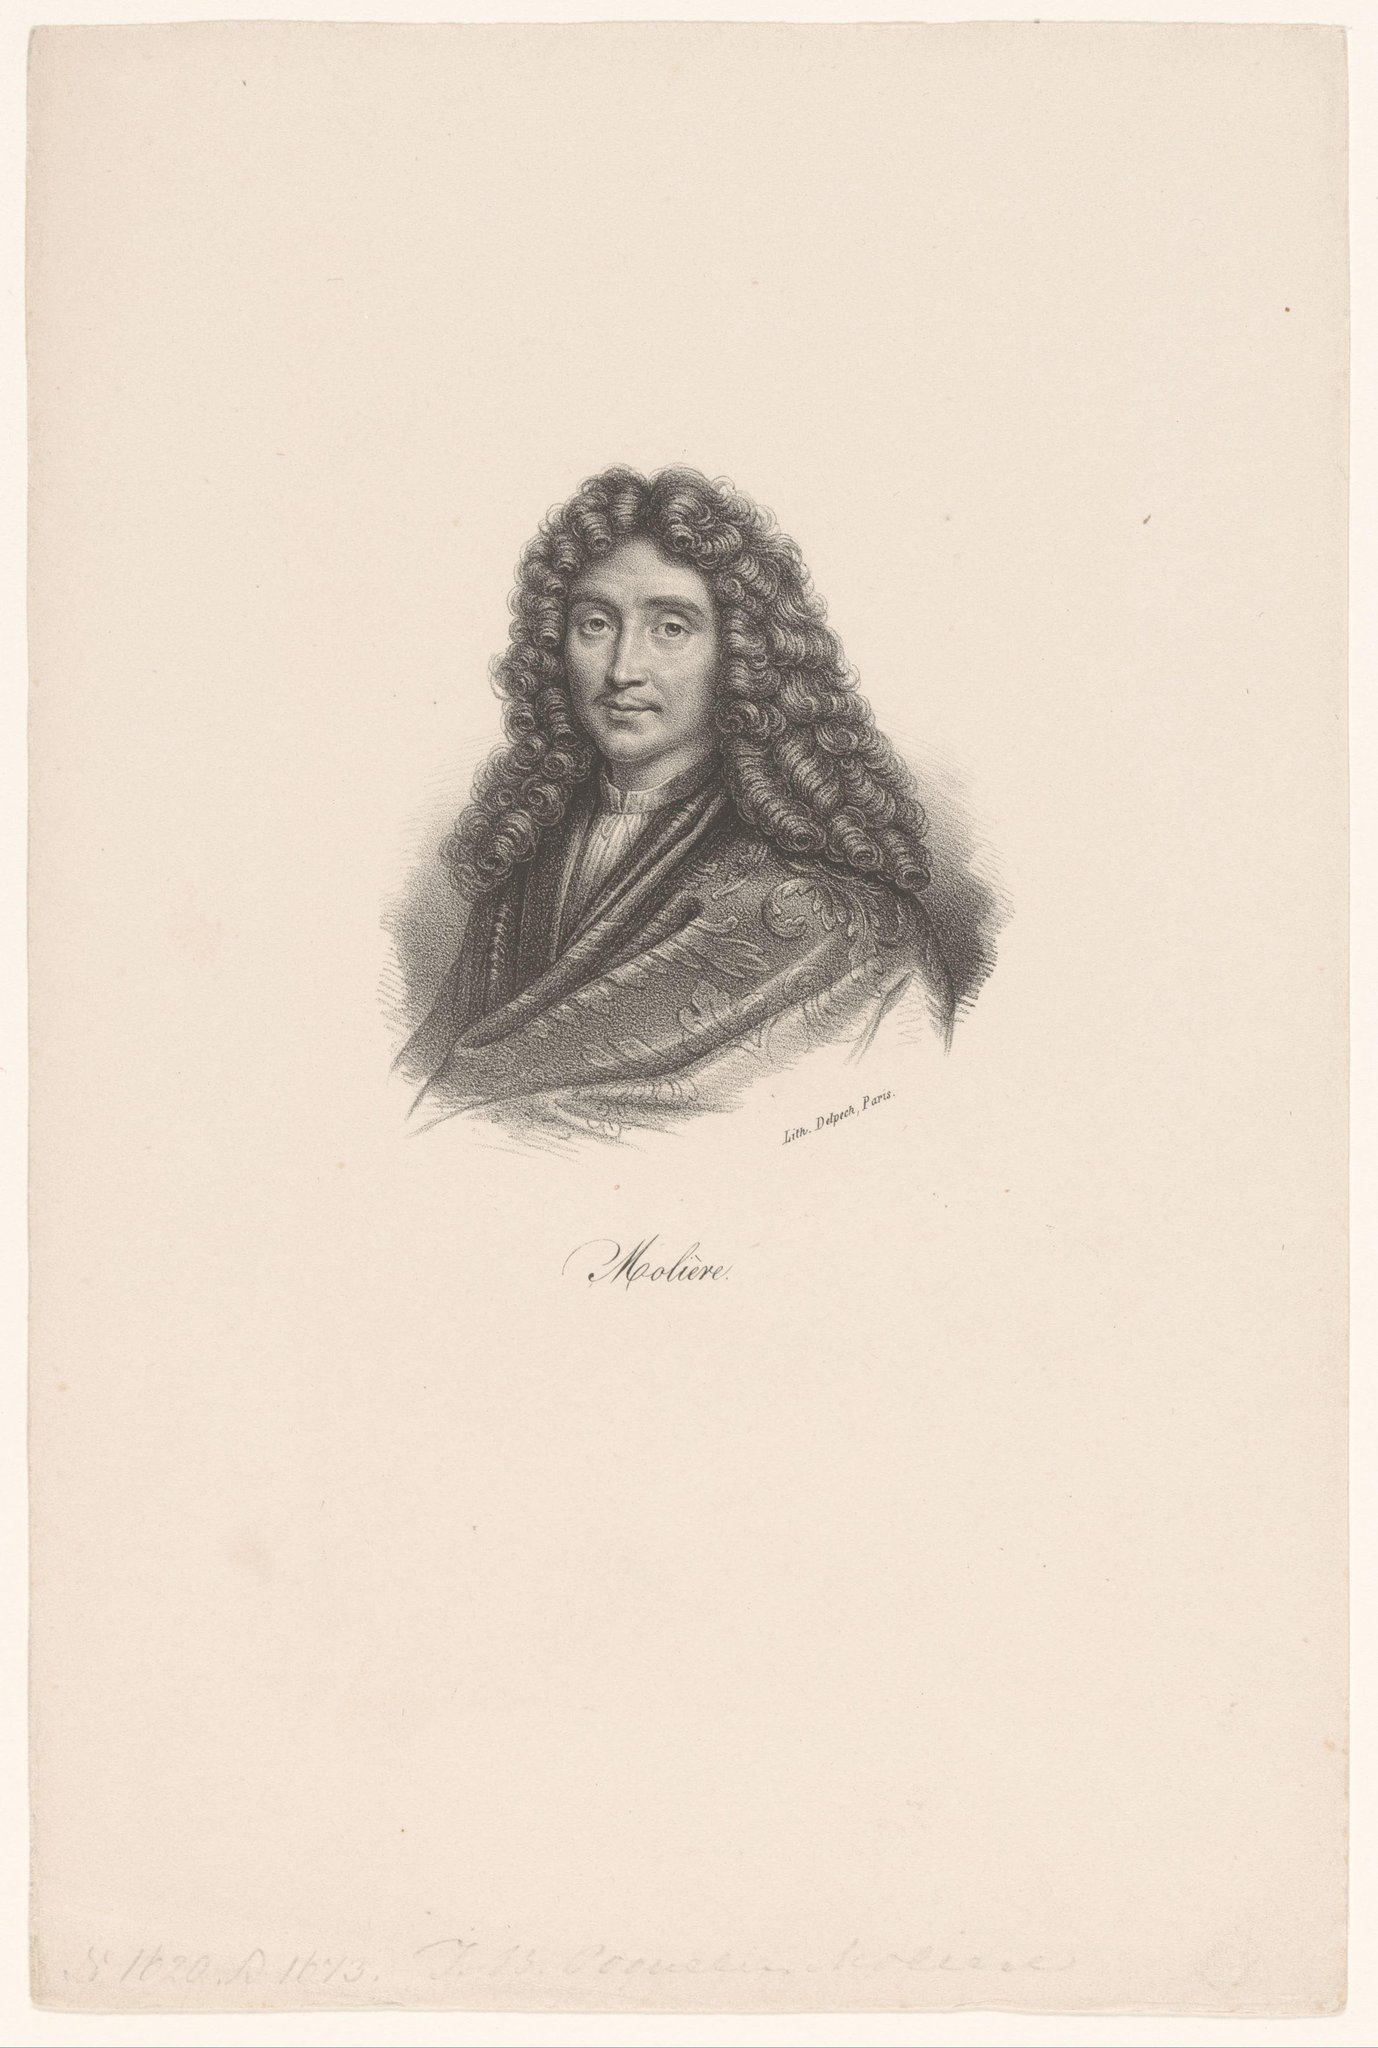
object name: print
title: Molière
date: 1818-1842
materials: paper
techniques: lithograph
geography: paris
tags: paris, jean baptiste poquelin molière, historical persons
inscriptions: collector's mark: Lugt 2228a